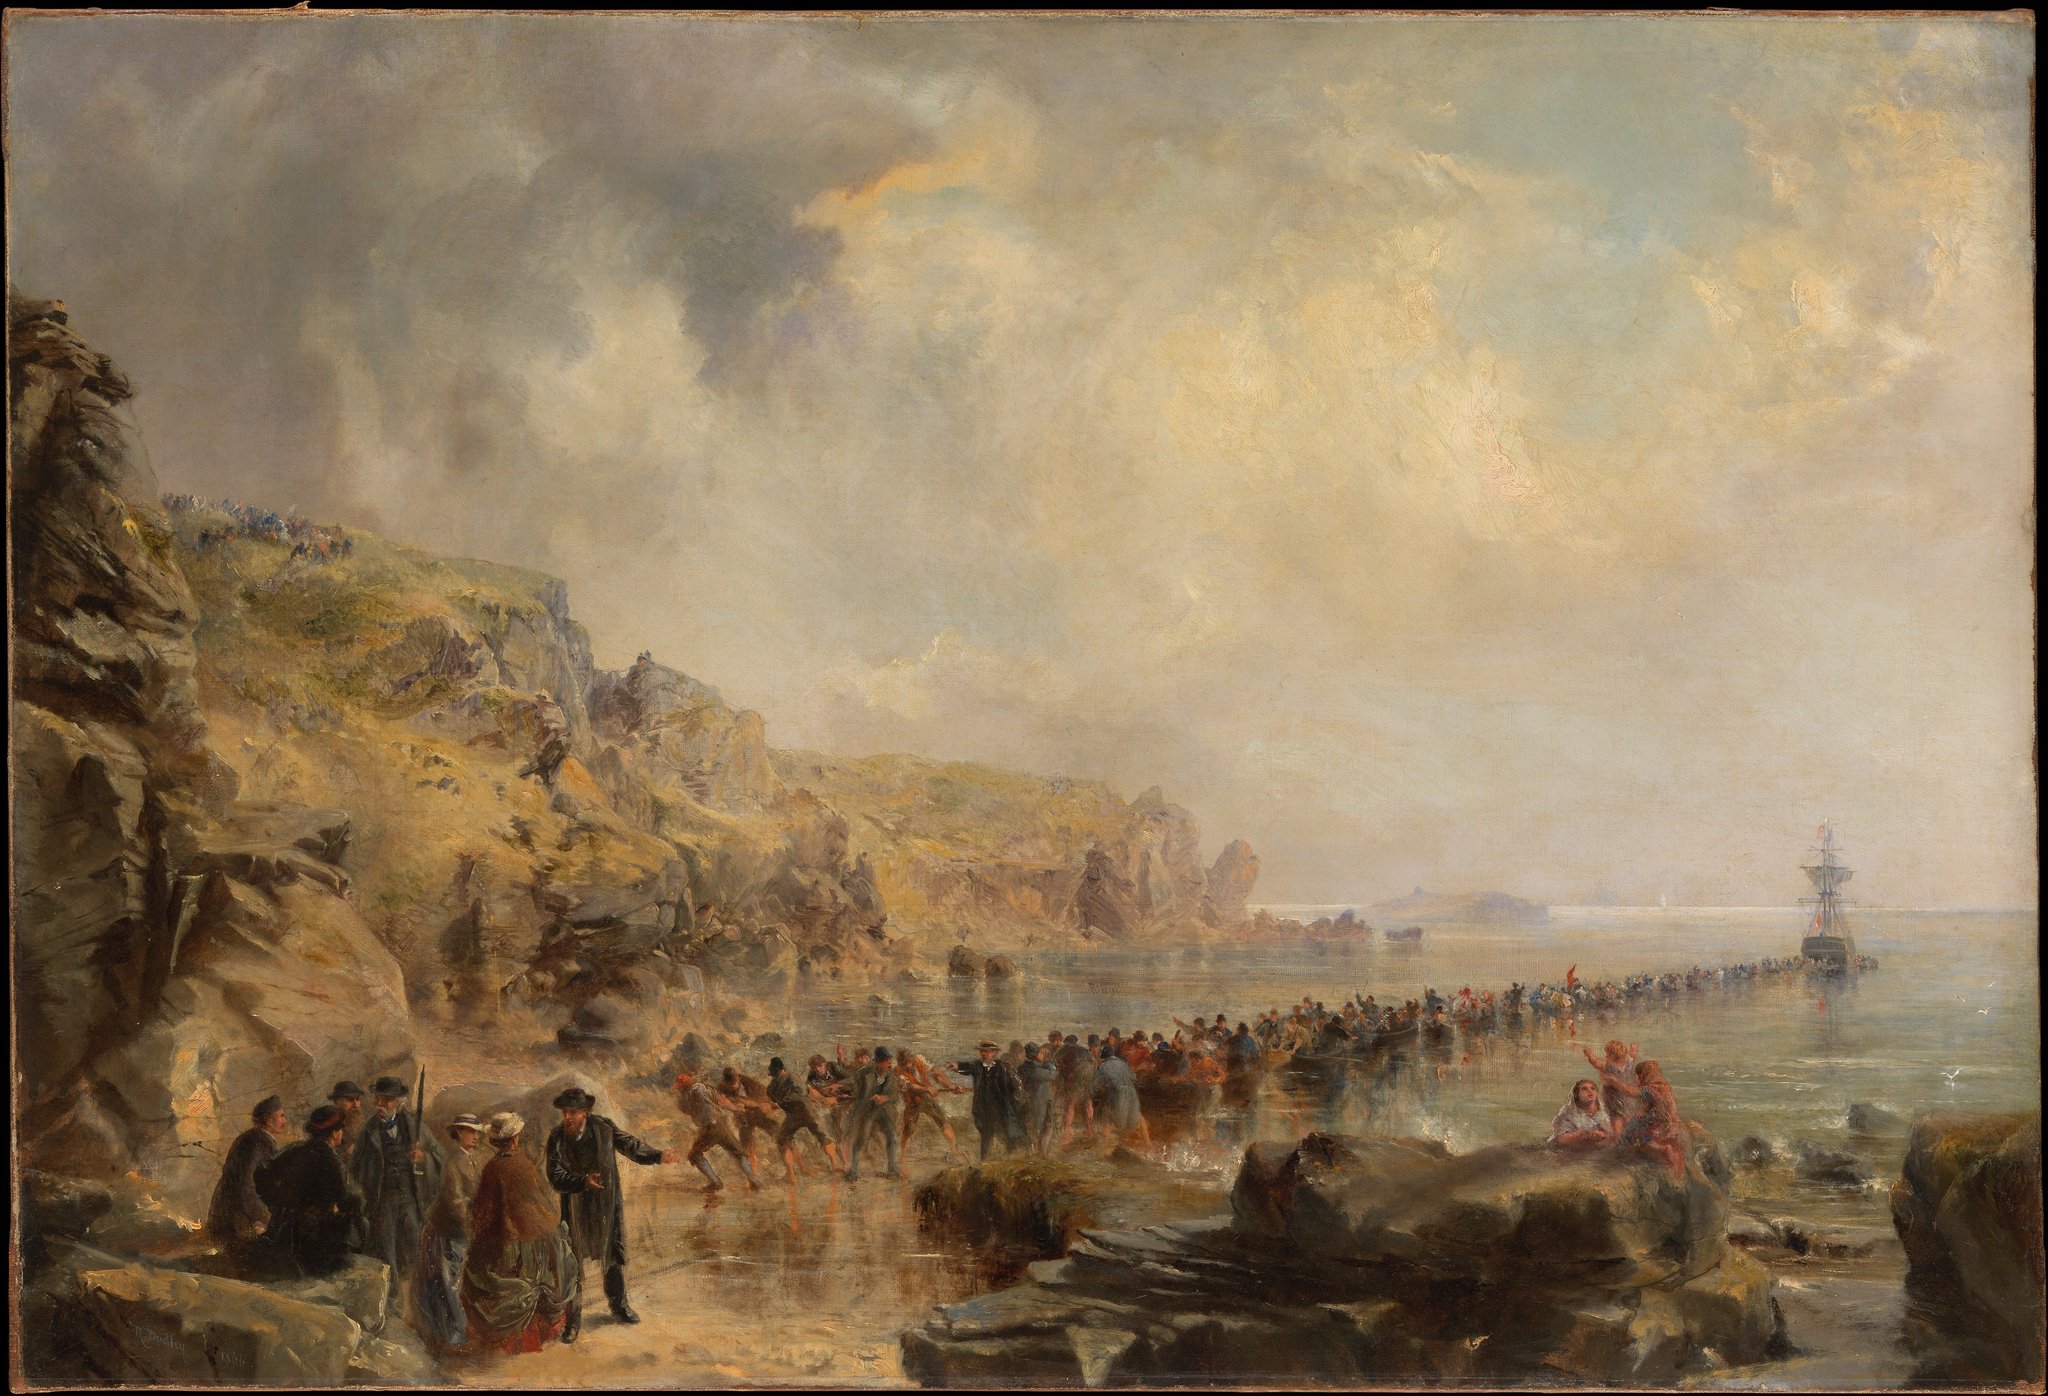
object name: painting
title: Landing the Shore End of the Atlantic Cable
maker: robert charles dudley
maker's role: artist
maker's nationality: british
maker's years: 1826-1909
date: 1866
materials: canvas, oil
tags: oceans,beaches,ships,transatlantic cable